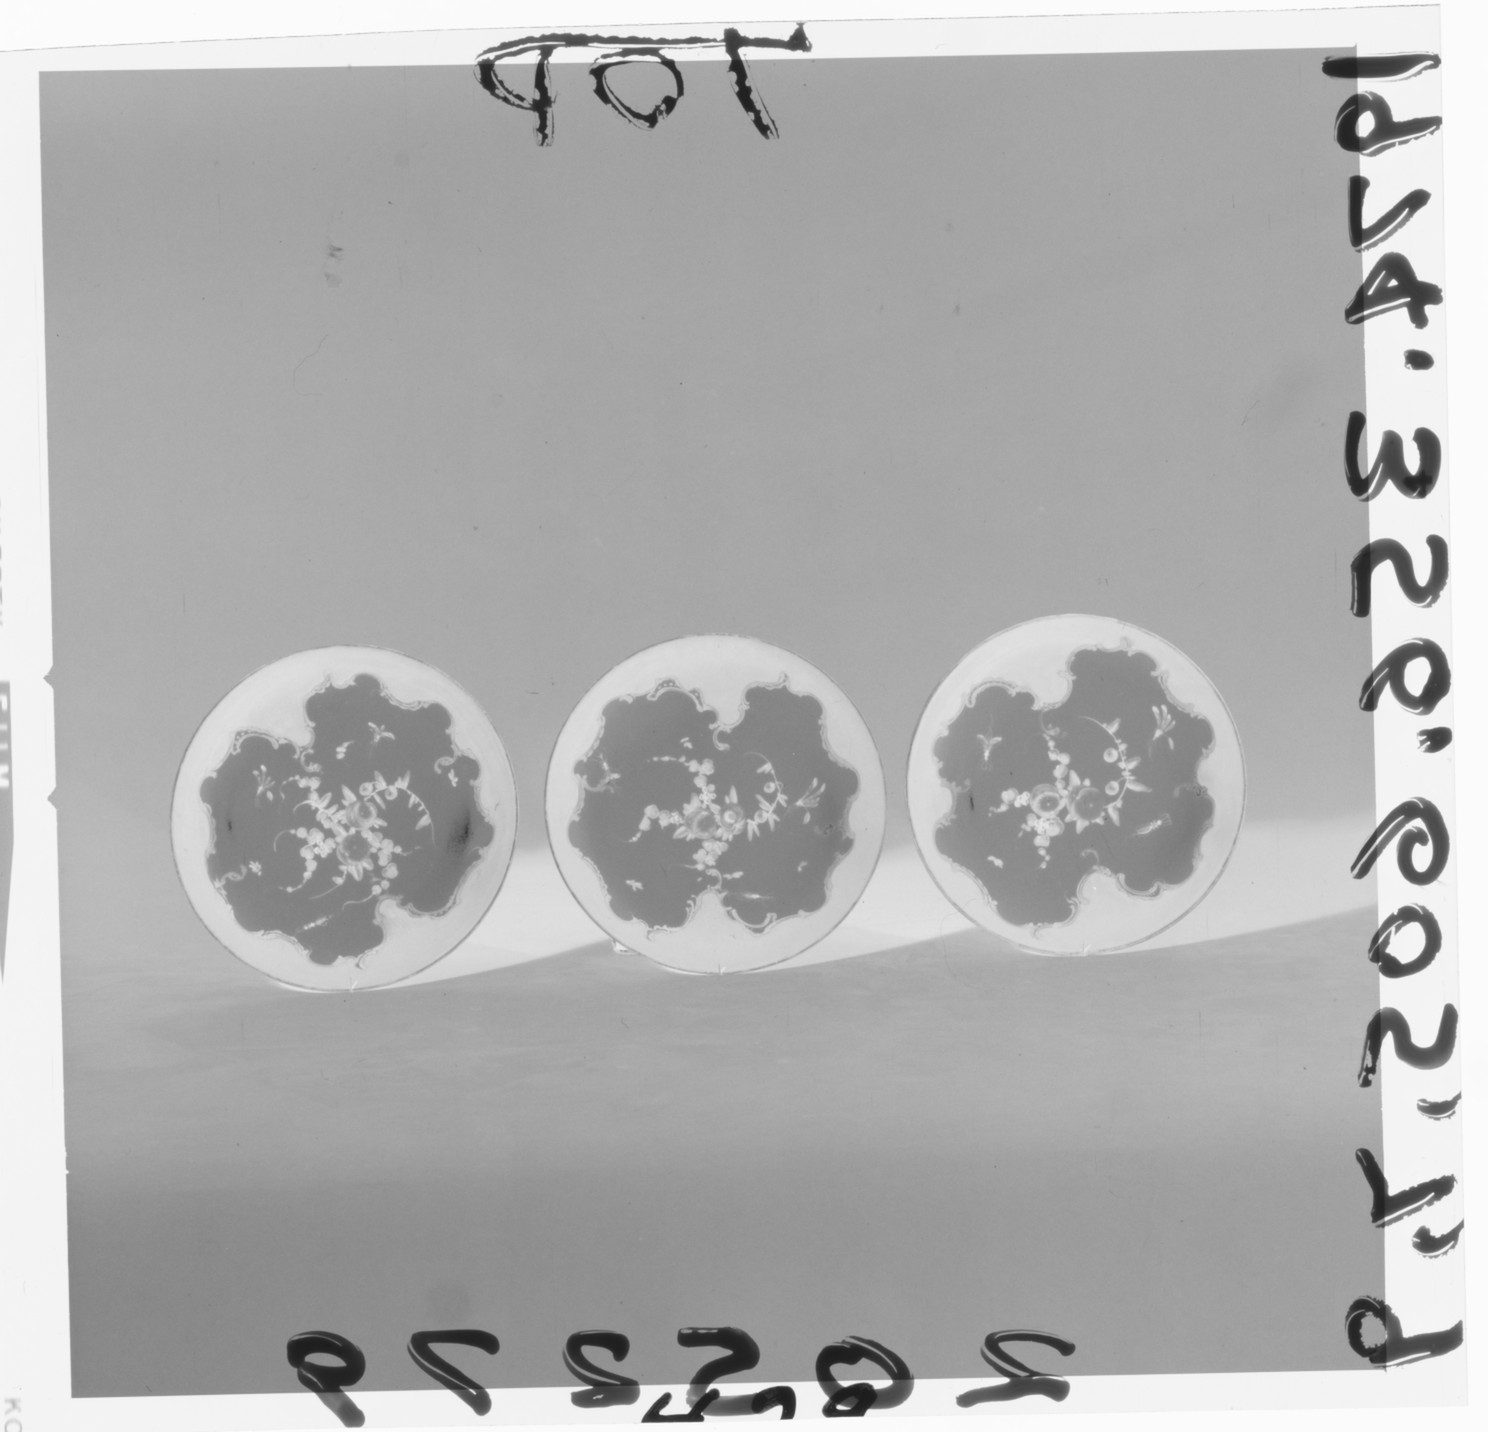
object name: saucer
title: Saucer (part of a service)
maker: worcester factory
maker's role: factory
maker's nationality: british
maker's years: 1751-2008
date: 1770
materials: soft paste porcelain